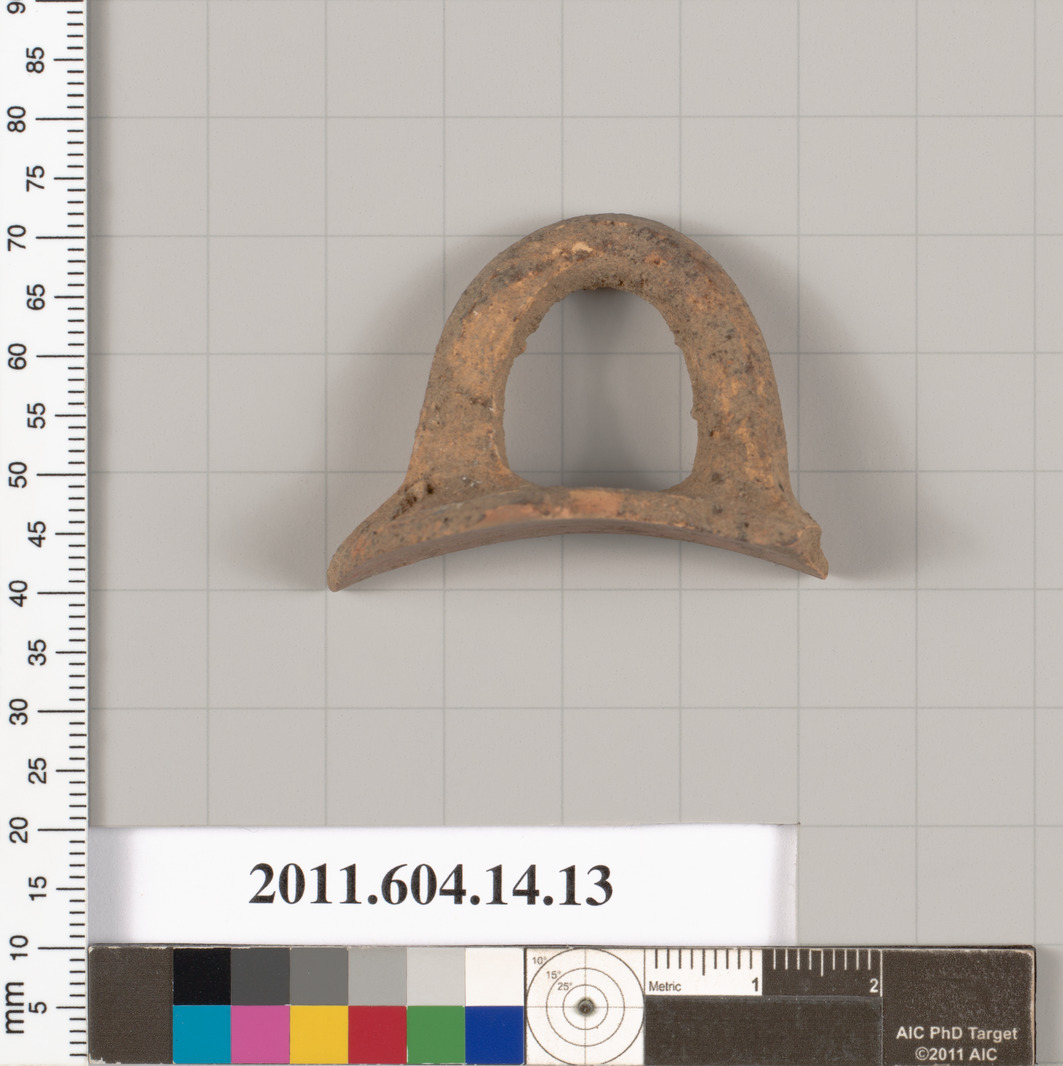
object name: skyphos fragment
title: Terracotta fragment of a skyphos?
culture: unknown fabric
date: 600-501 BCE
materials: terracotta